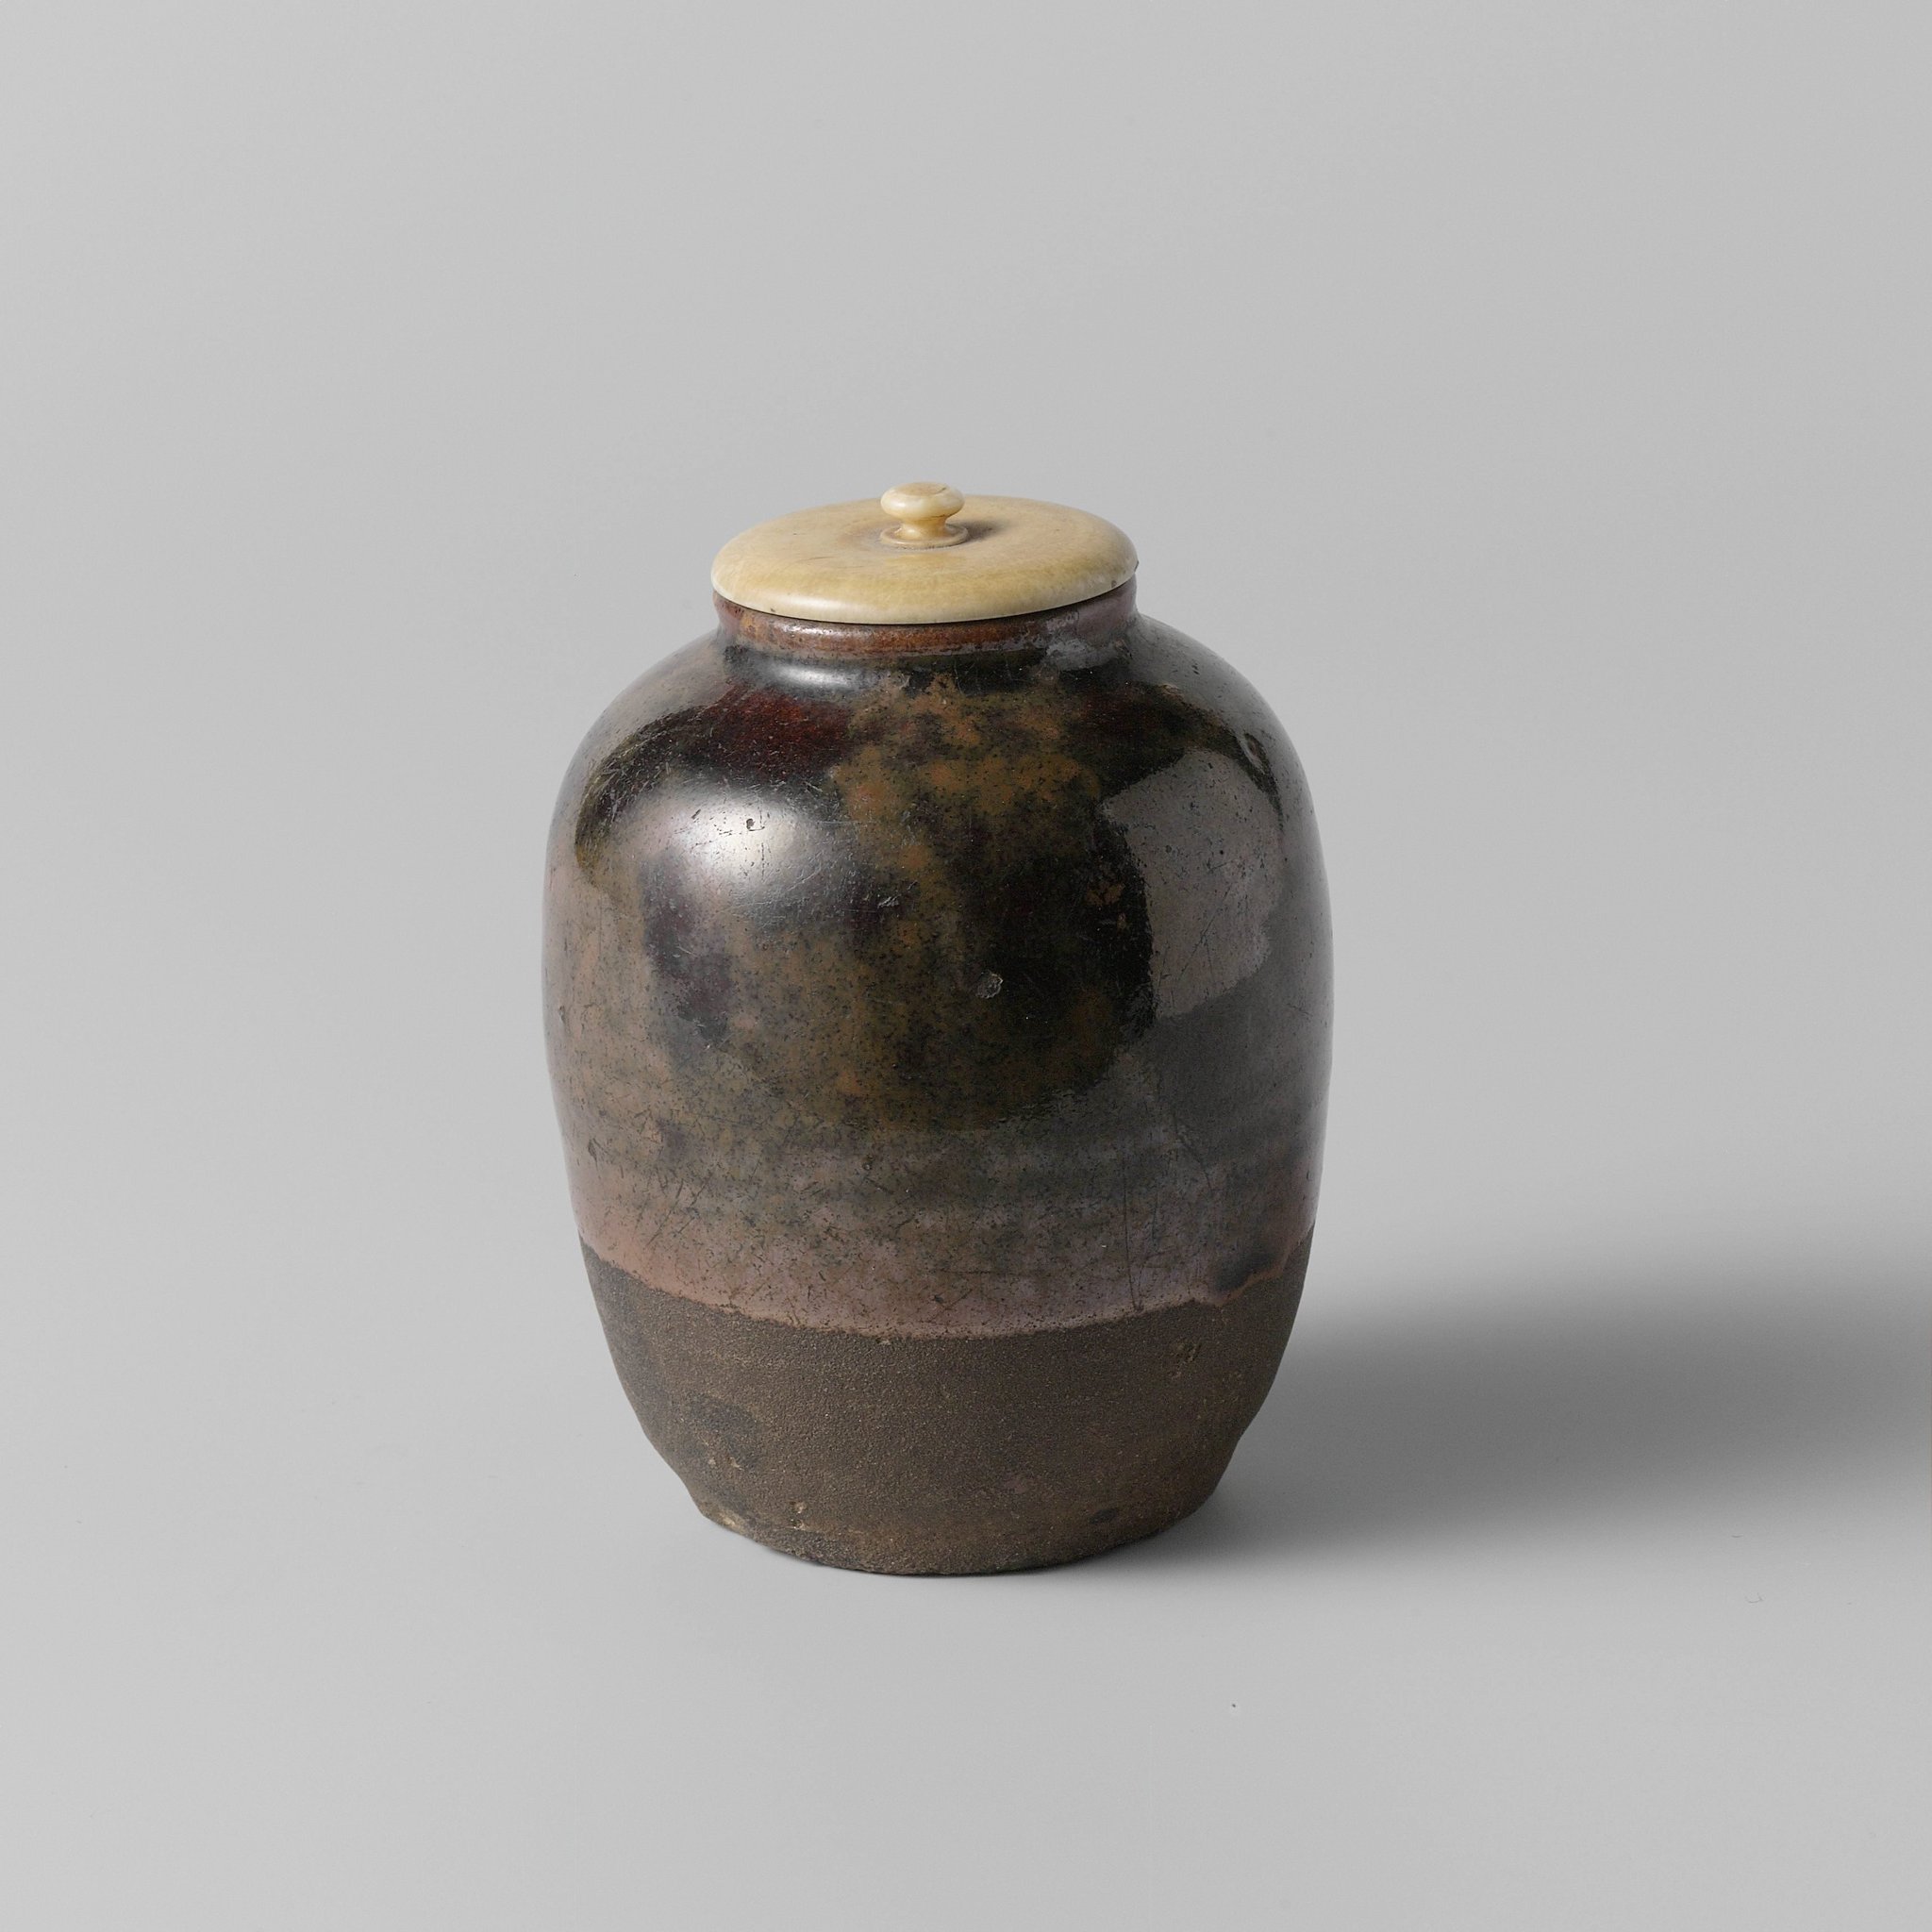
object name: chaire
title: Teacaddy with a goldenbrown glaze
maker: Anonymous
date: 1700-1800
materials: glaze, ivory, stoneware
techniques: firing, turning, vitrification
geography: seto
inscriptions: label: ‘Takatori (inkyu-shu)/ 18e’, label: ‘W637’, label: ‘ko-seto’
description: Stoftheebus of chaire van steengoed met een ivoren deksel, gedeeltelijk bedekt met een goudbruin glazuur. De onderste helft van de bus is ongeglazuurd. Oud label op de onderzijde met 'W637'; twee oude labels aan de binnenzijde met 'Takatori (inkyu-shu)/ 18e' en 'ko-seto'. Seto.